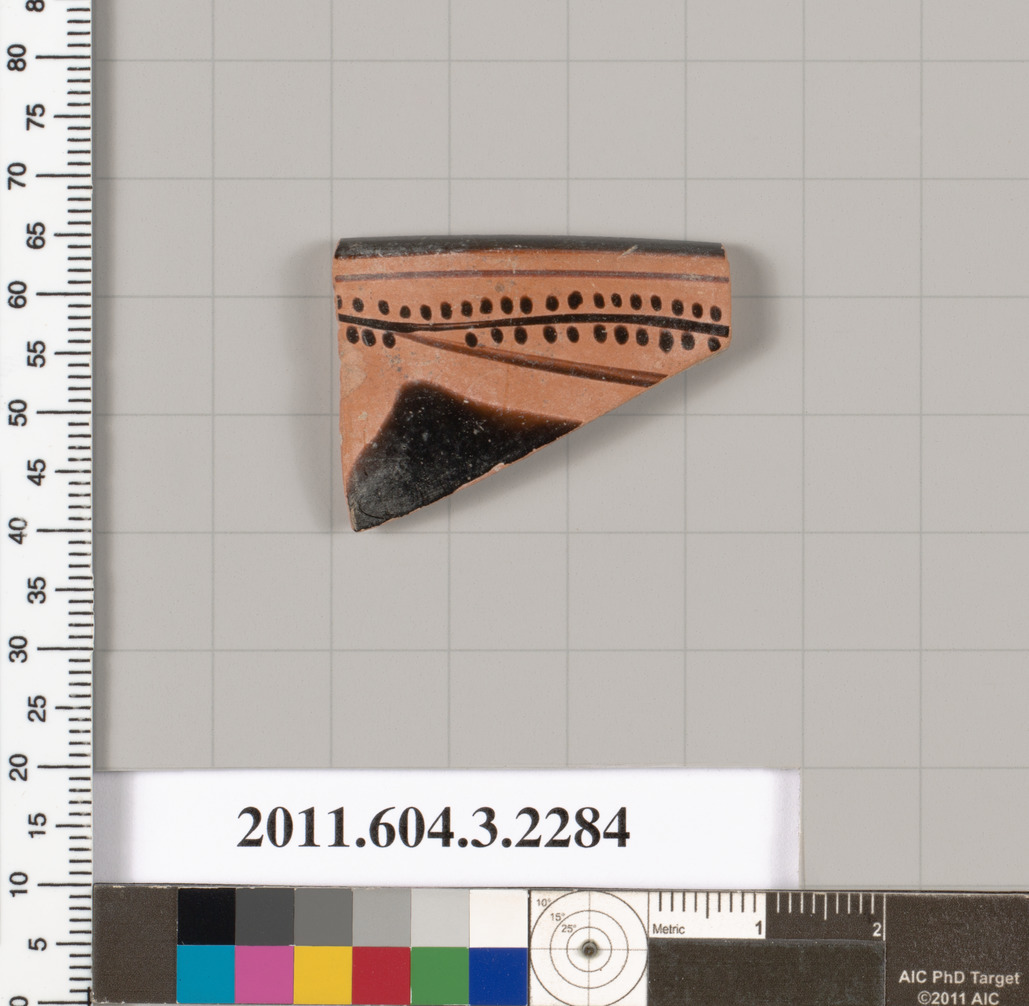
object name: kylix fragment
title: Terracotta rim fragment of a kylix: eye-cup (drinking cup)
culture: greek, attic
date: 525-501 BCE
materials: terracotta